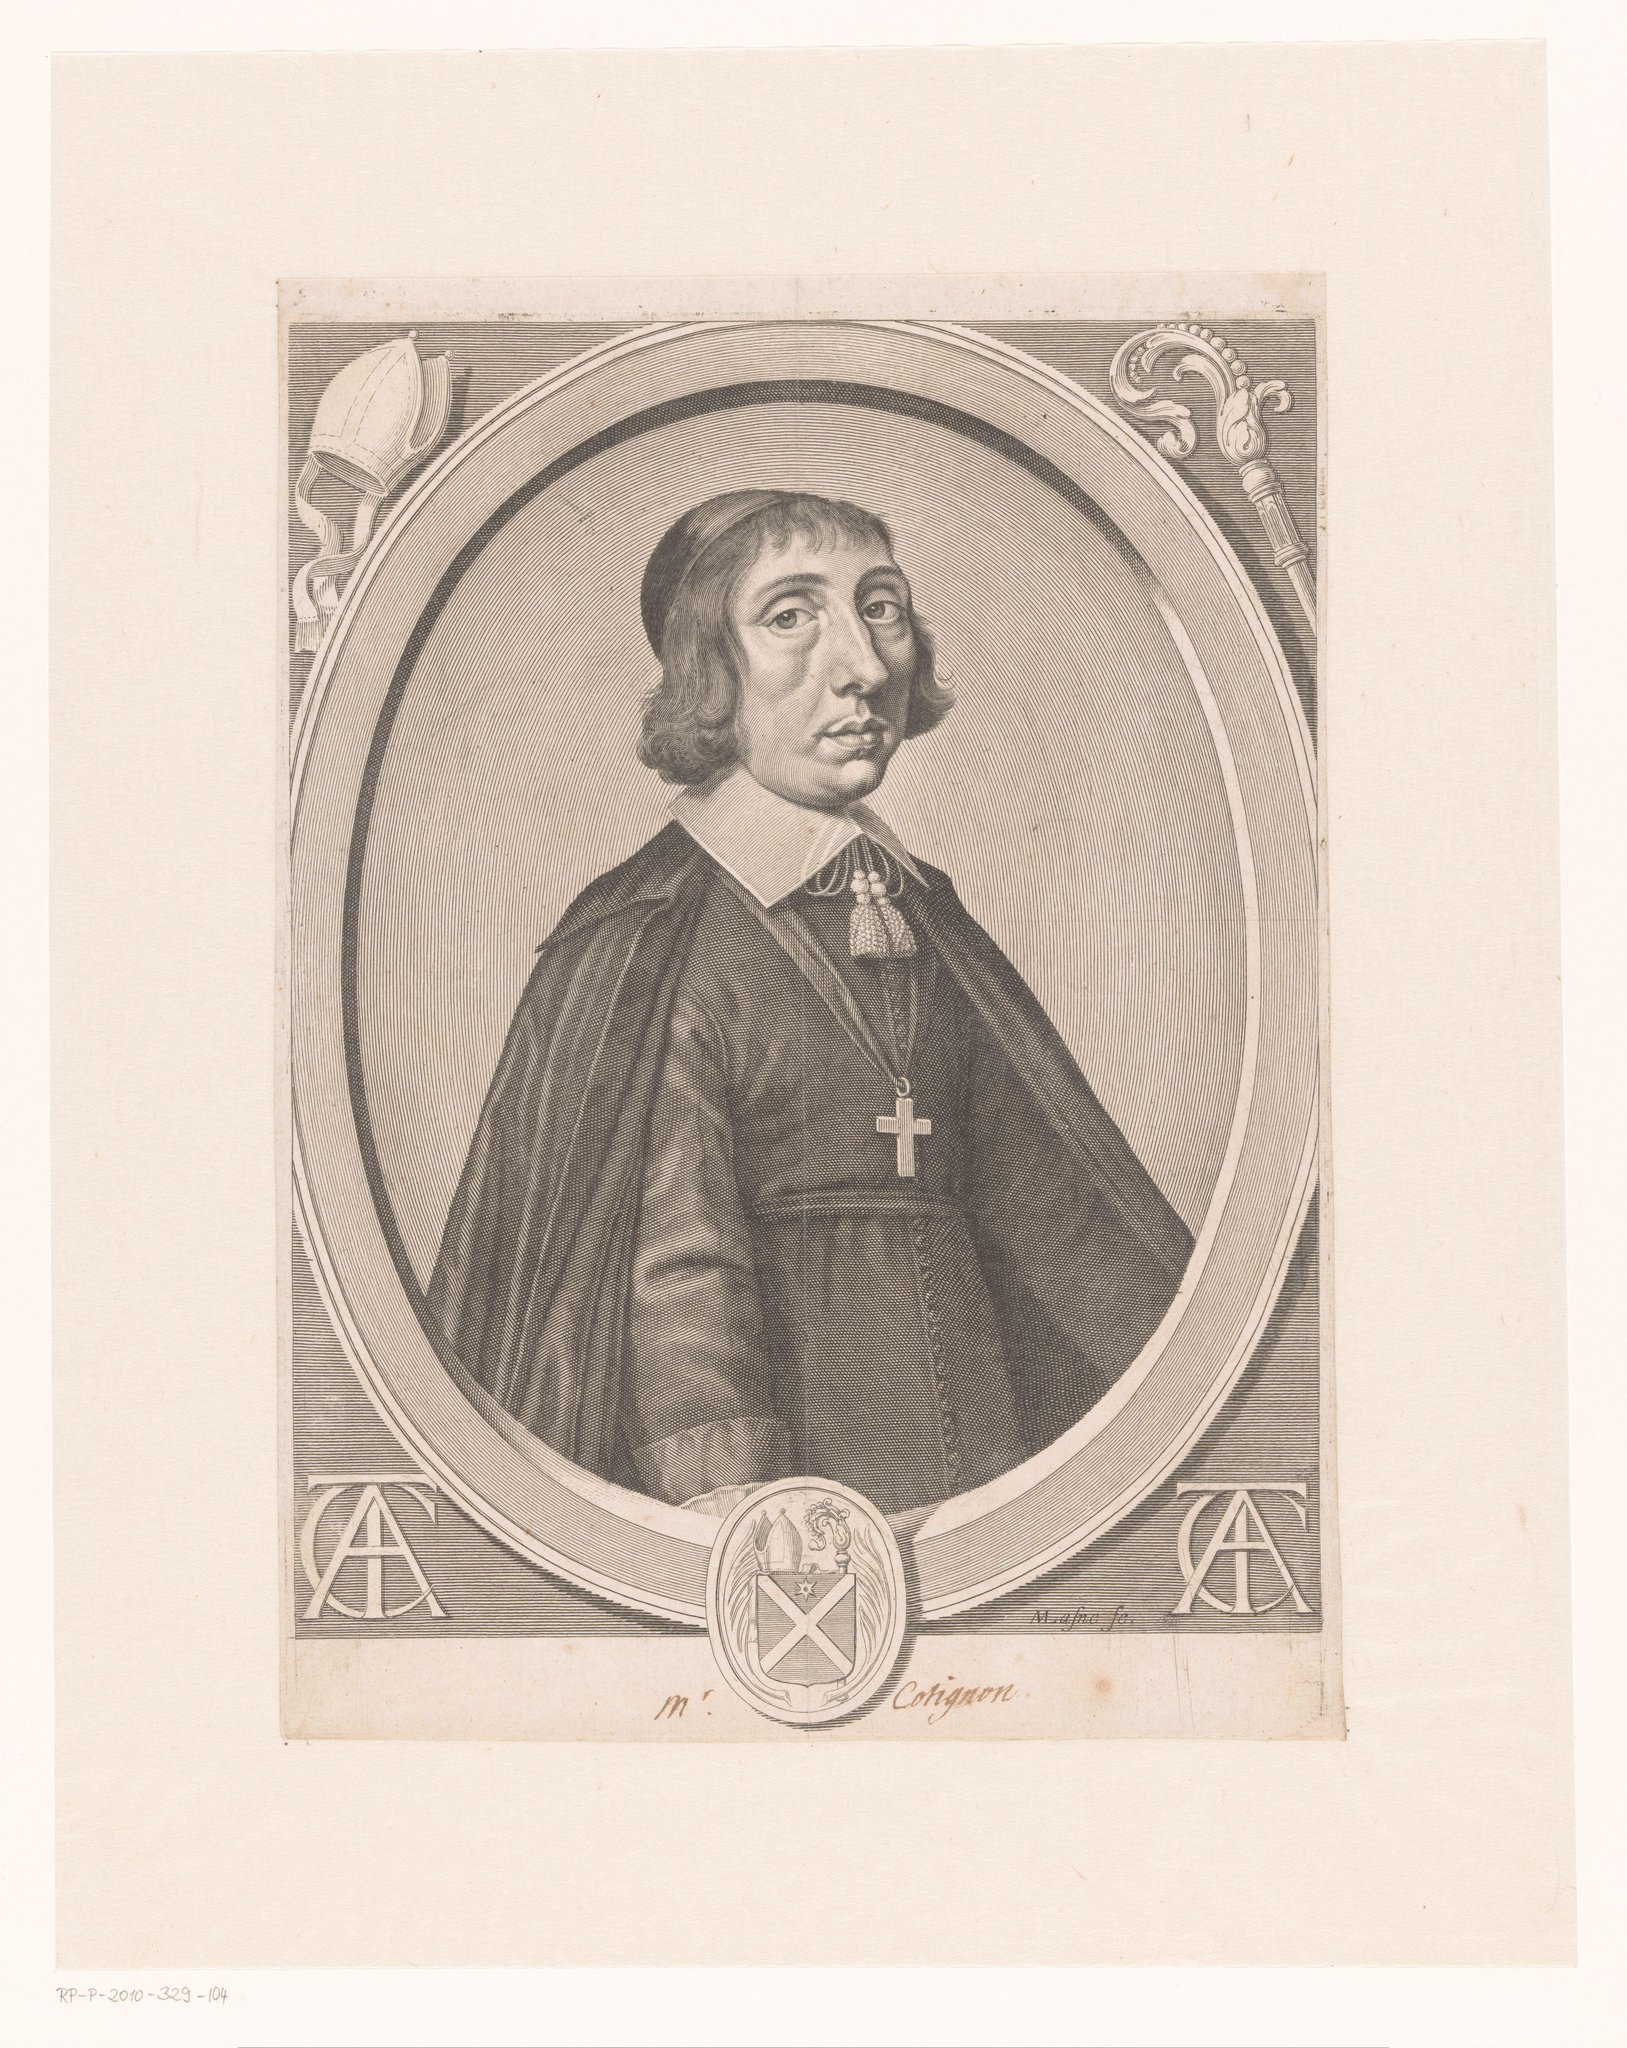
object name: print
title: Portret van Antoine Cotignon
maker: michel lasne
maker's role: print maker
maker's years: 1590-1667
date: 1600-1667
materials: paper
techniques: engraving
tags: insignia of bishop, e.g. mitre, crozier, historical persons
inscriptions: inscription: ‘Mr. Colignon’, collector's mark: Lugt 2228